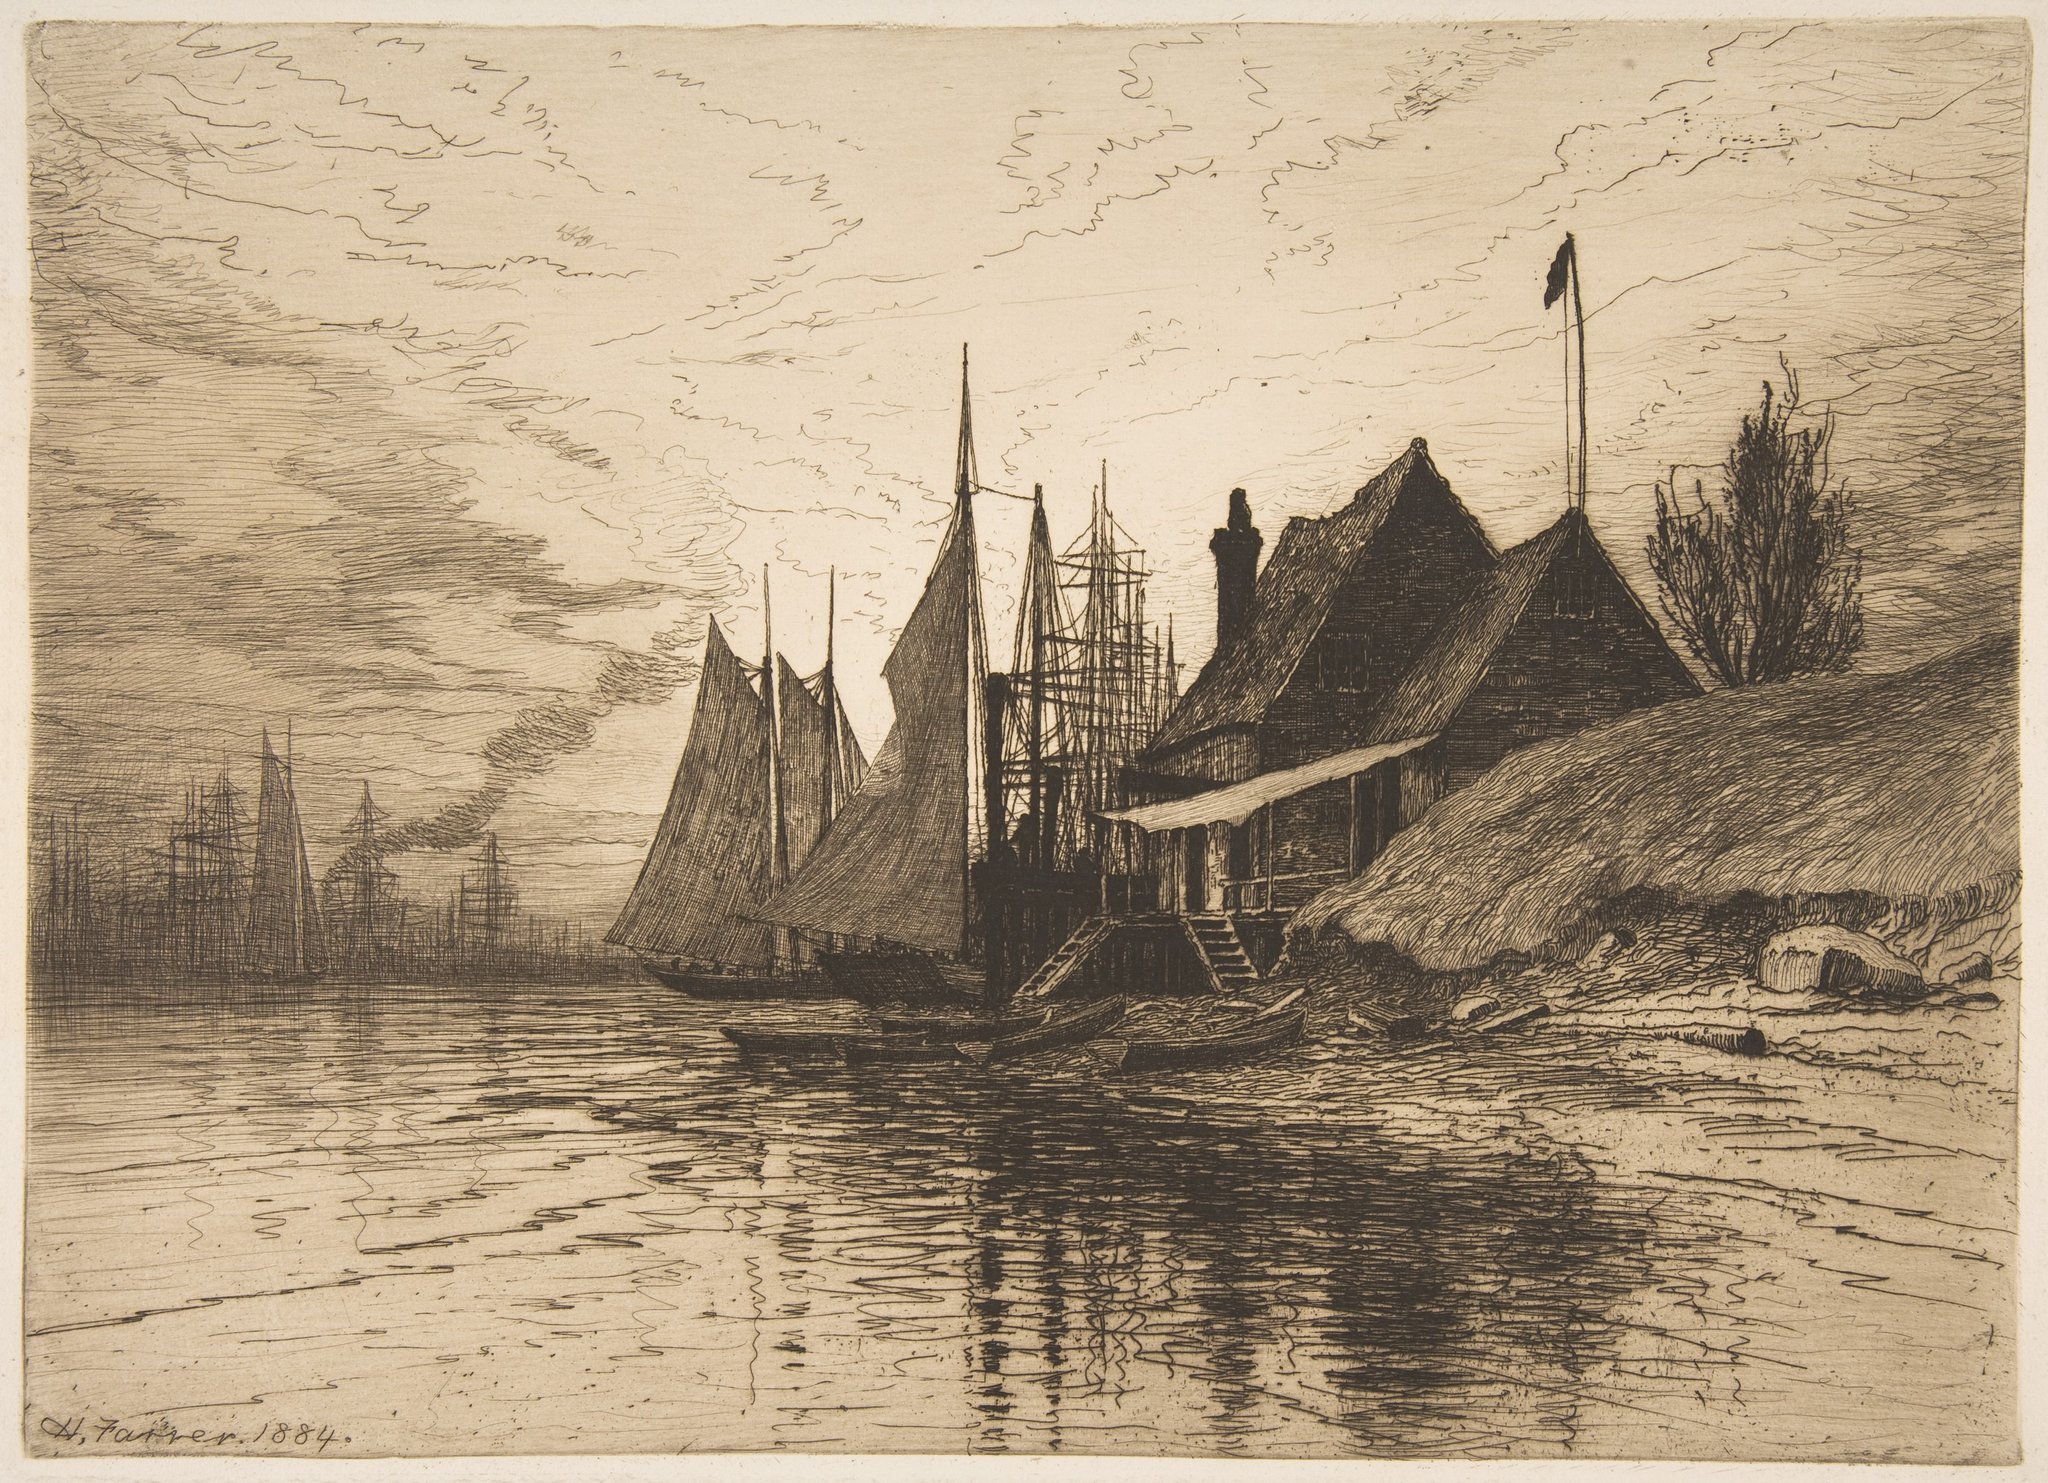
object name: print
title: Evening, New York Harbor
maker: henry farrer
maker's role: artist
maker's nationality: american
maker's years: 1844-1903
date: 1884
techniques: etching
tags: houses,landscapes,evening,boats,new york city